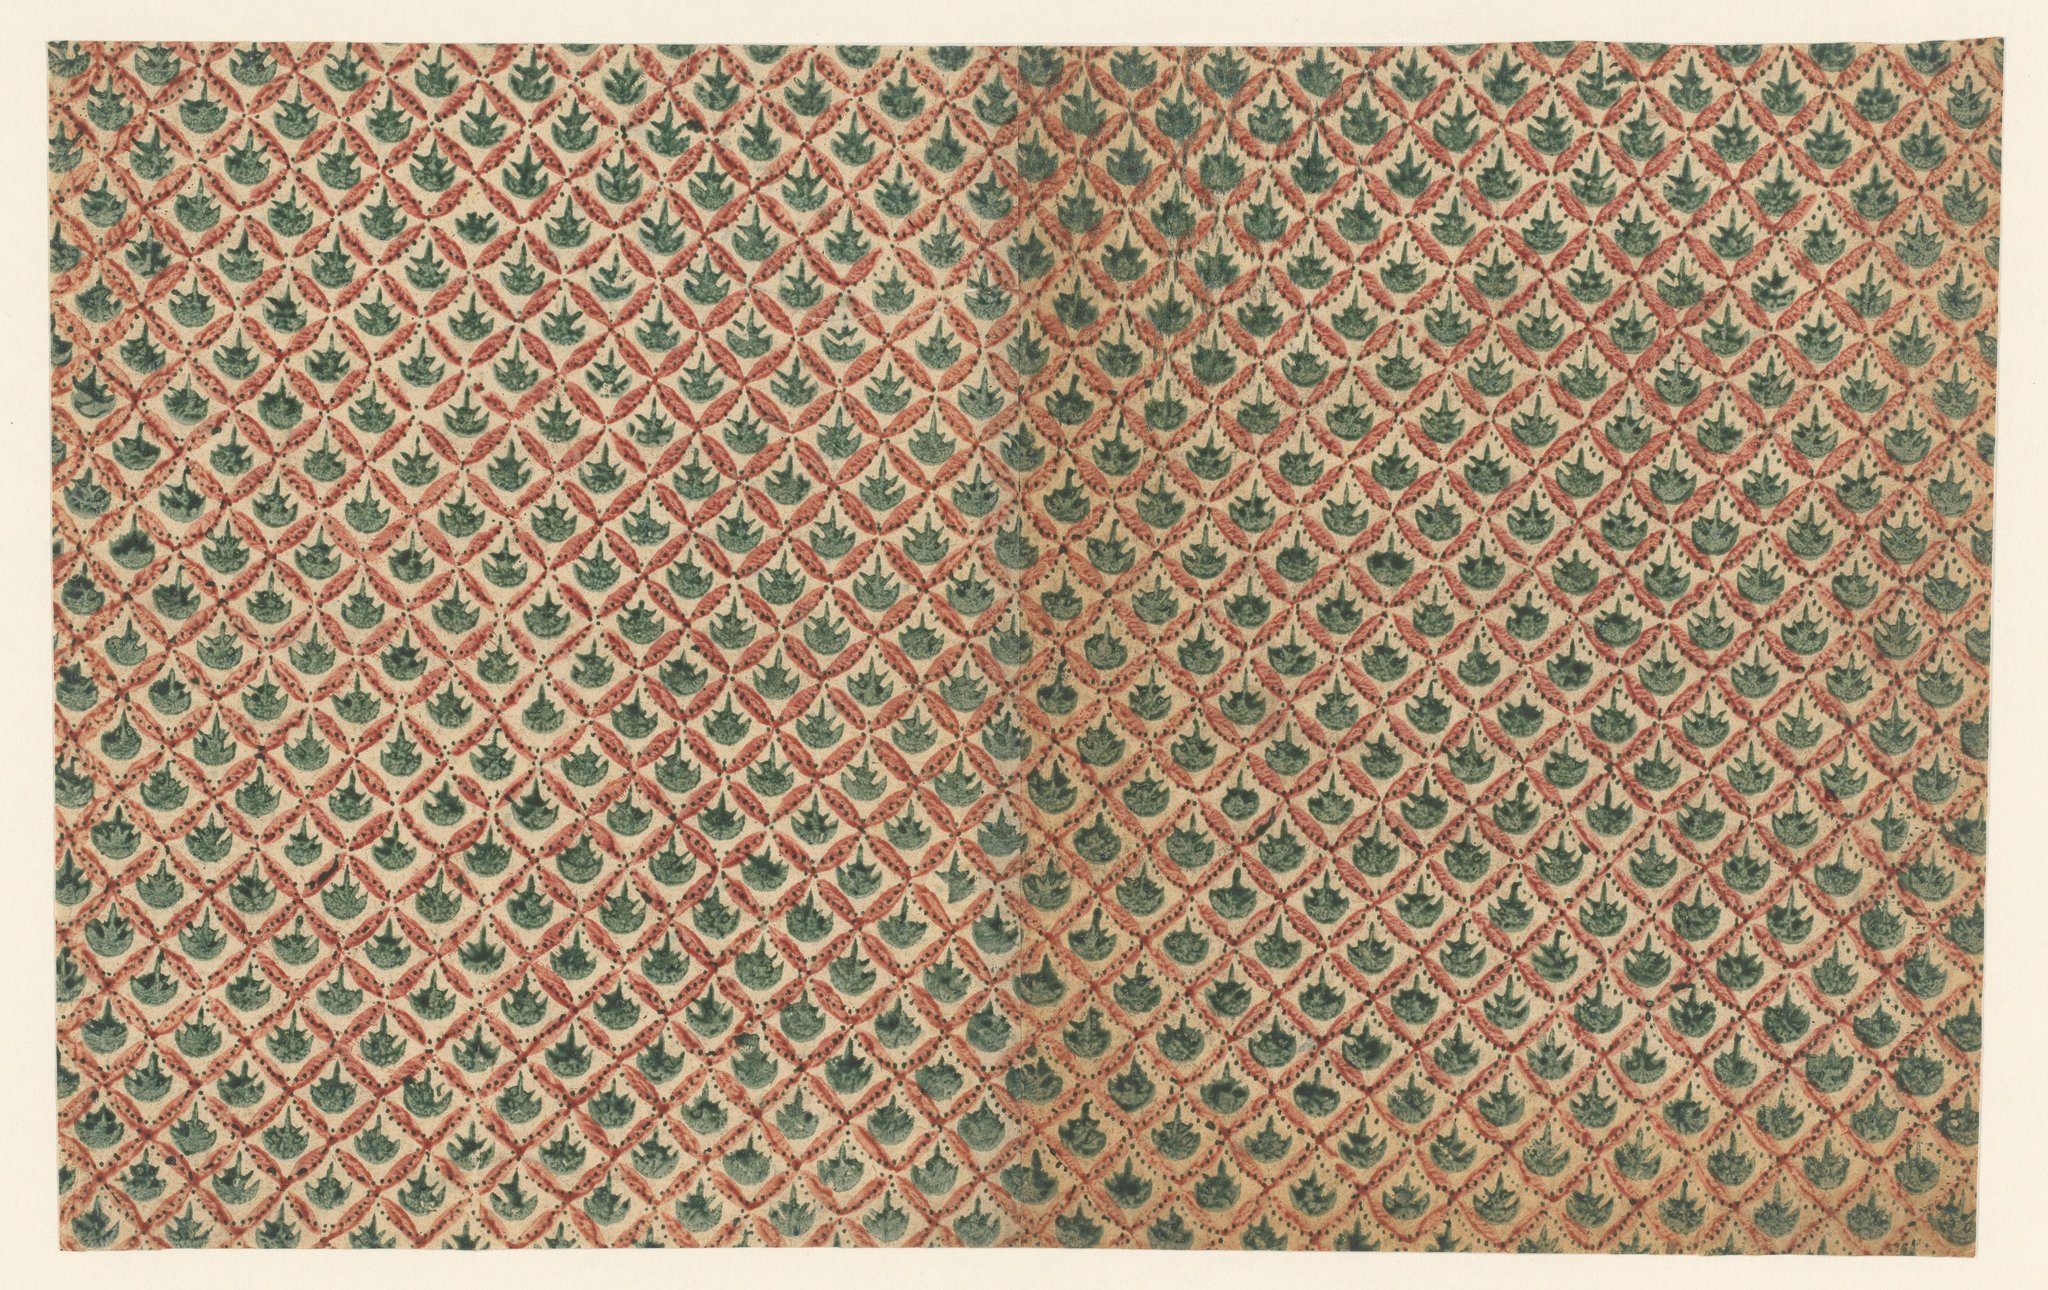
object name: printed paper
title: Blad met ruitenpatroon van bladmotief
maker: Anonymous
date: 1700-1850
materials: paper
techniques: printing block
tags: ornament derived from plant forms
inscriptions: annotation: ‘Hengel oratie 1818’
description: Blad met ruitenpatroon met bladmotief als veldvulling. Gebruikt als omslag voor een publicatie uit 1818.